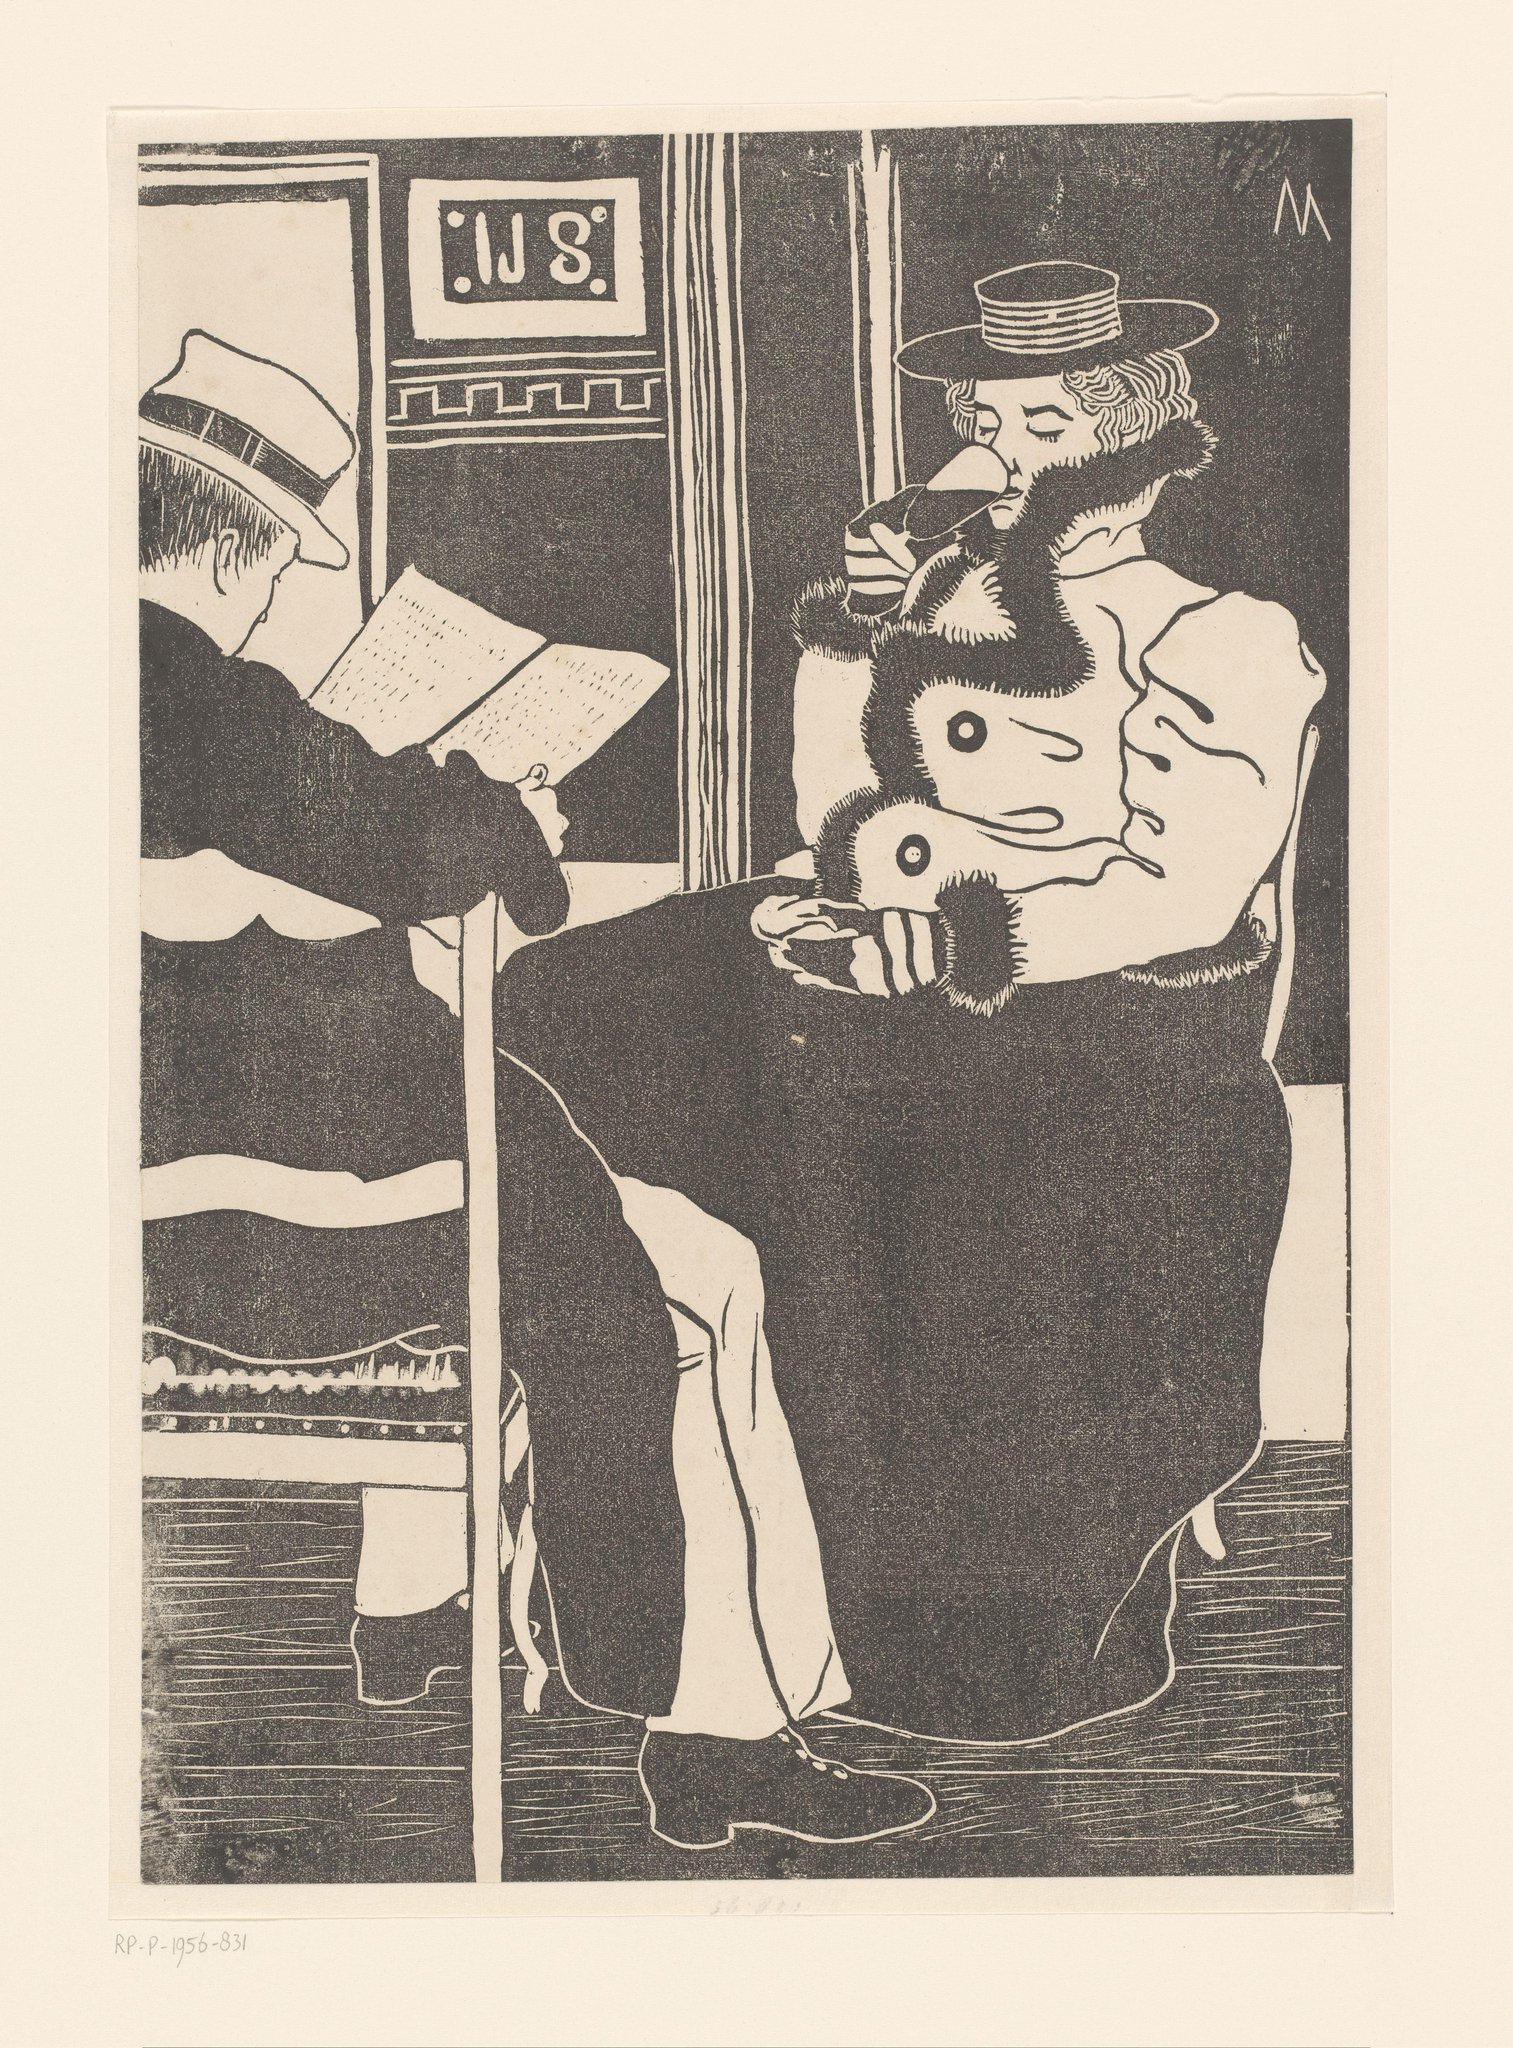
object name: print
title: In 't café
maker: samuel jessurun de mesquita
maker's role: draughtsman, print maker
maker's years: 1868-1944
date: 1898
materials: paper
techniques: woodcut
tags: reading, inn, coffee-house, public house, etc., drinking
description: Prent gebruikt voor: Meier-Graefe, J. 'Jesurum di Mesquita'. Dekorative Kunst. Illustrierte Zeitschrift für Angewandte Kunst, 2 (1899) 4, pp. 7, 9, 32, 39, 40.